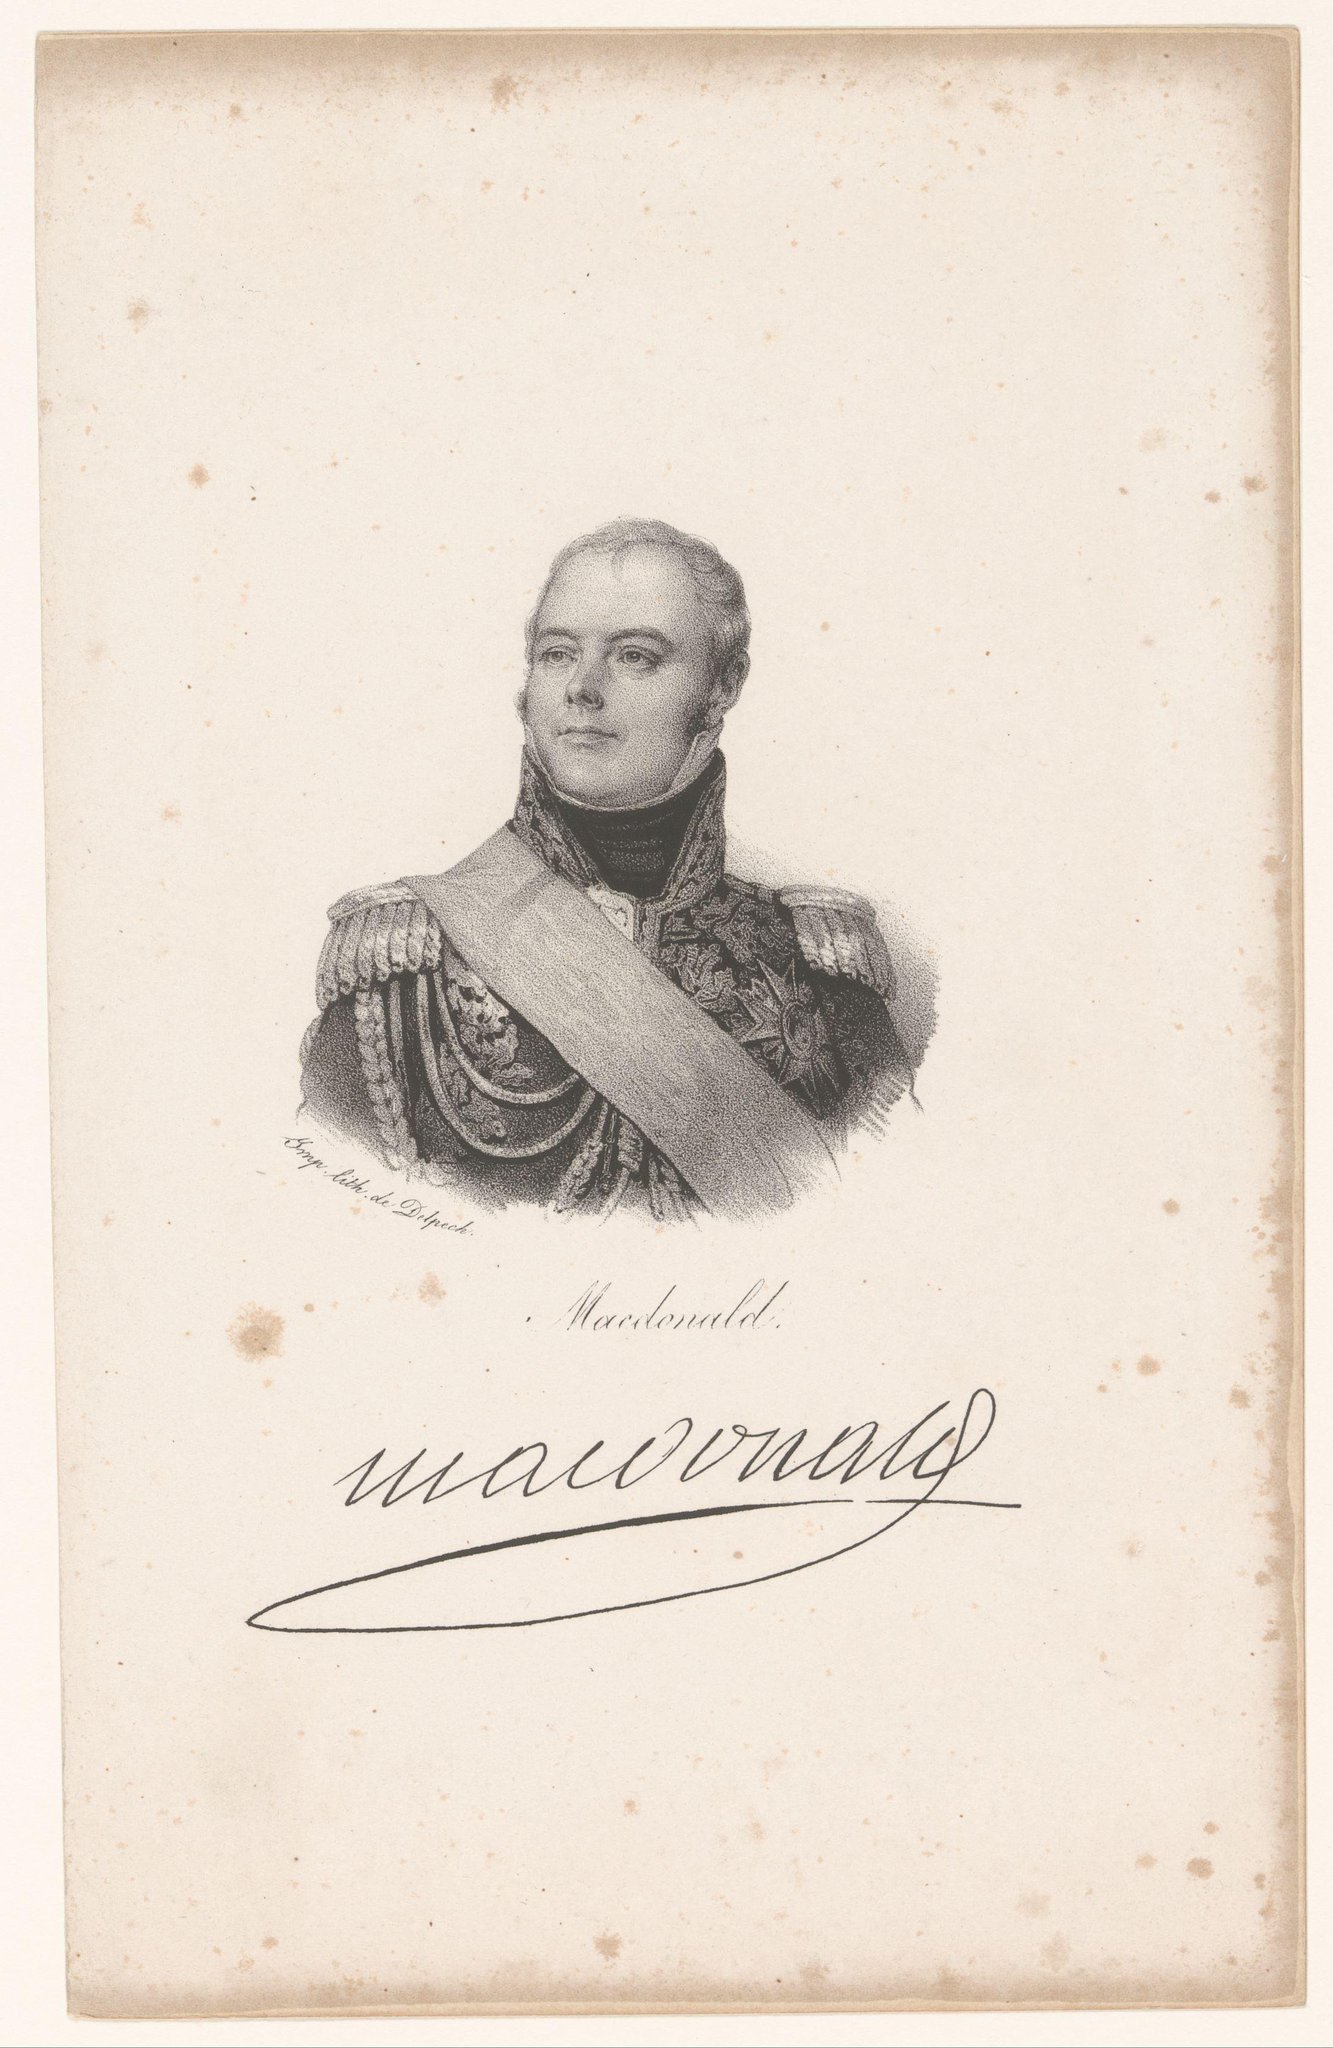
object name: print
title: Macdonald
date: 1818-1842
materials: paper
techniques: lithograph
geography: paris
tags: historical persons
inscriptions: collector's mark: Lugt 2228a